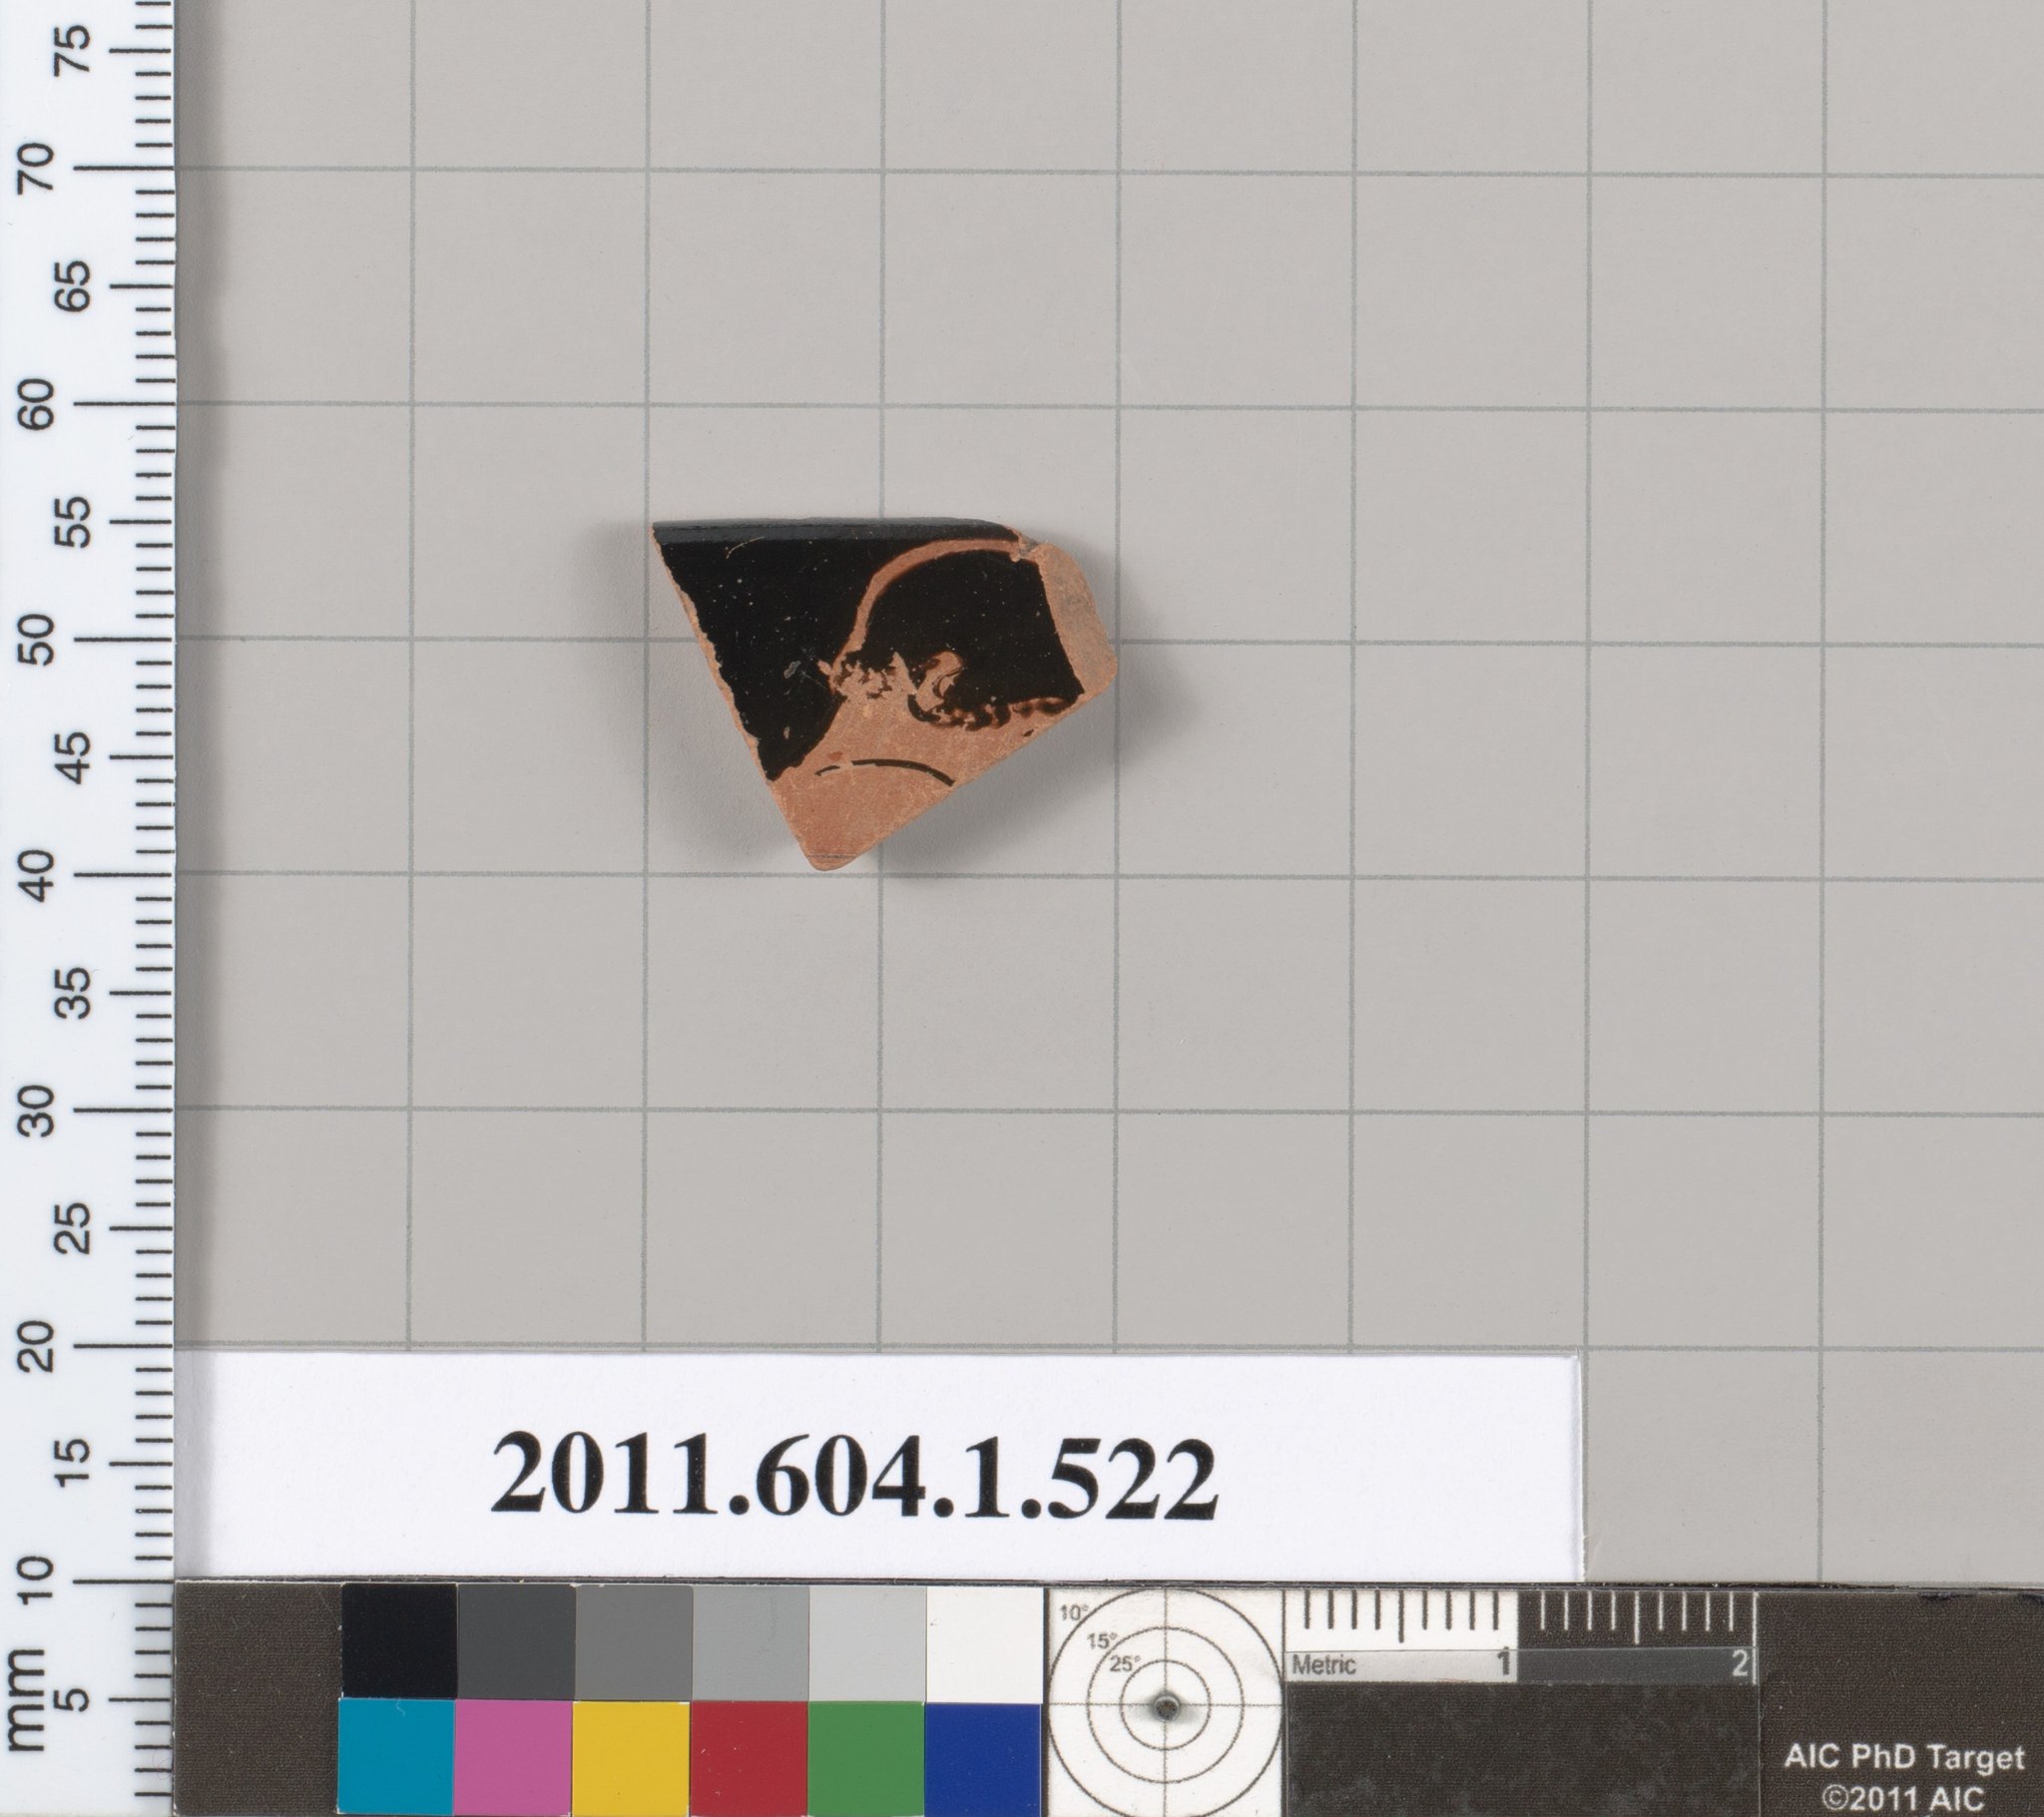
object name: kylix fragment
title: Terracotta rim fragment of a kylix (drinking cup)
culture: greek, attic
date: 490-480 BCE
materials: terracotta